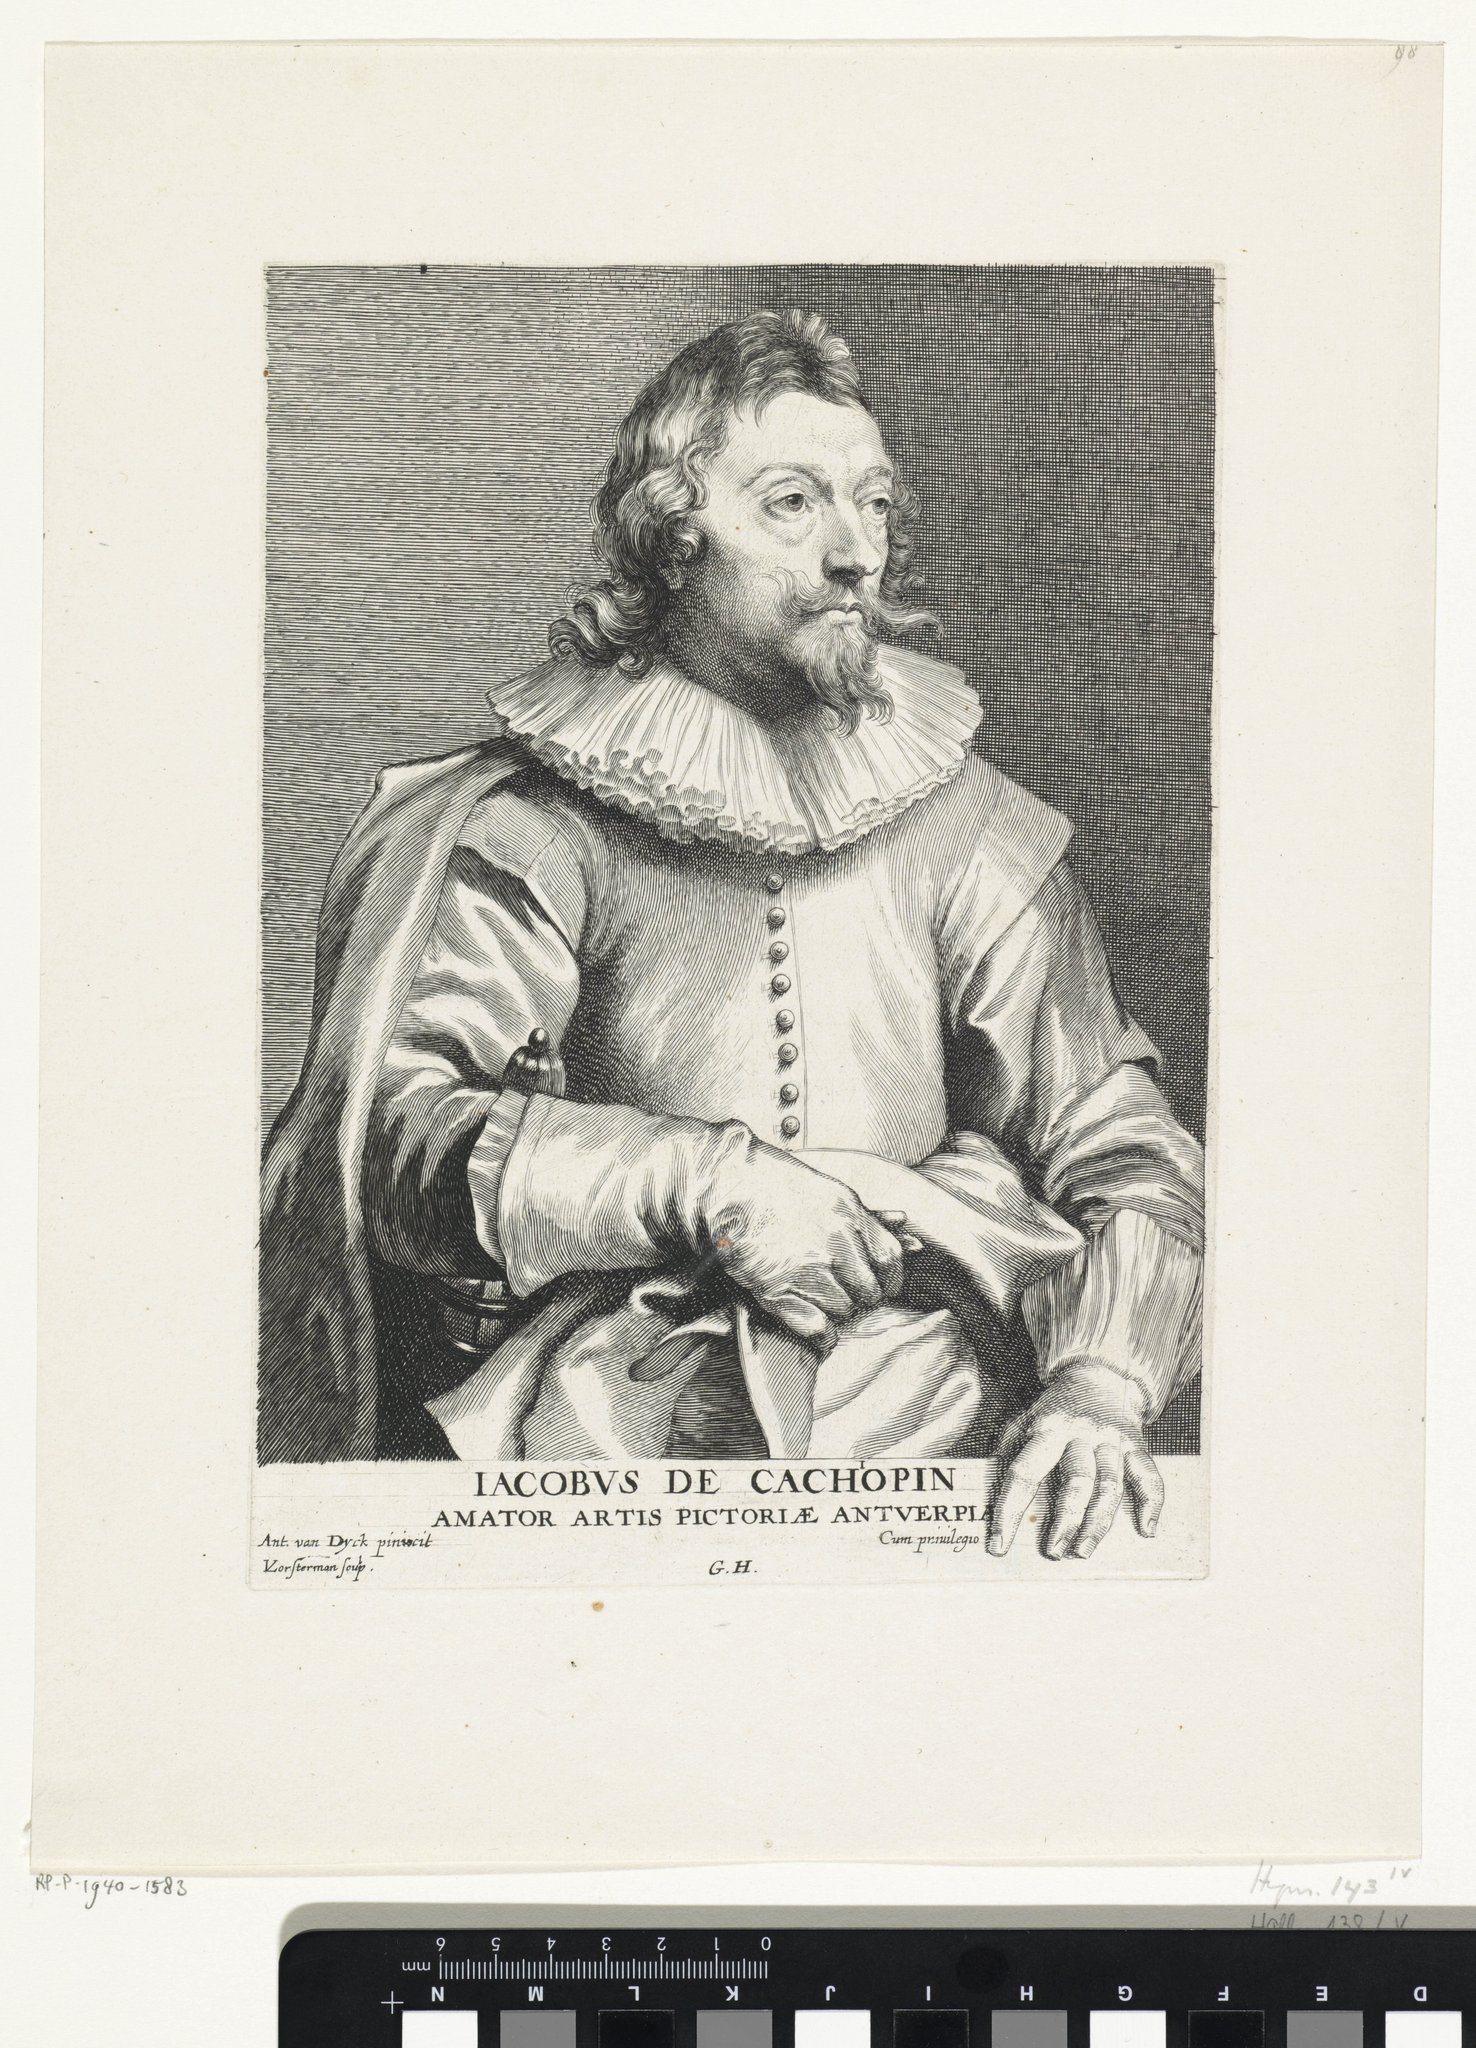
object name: print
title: Iconographie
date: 1645-1646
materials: paper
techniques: engraving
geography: antwerp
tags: gloves, mittens, etc.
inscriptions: collector's mark: Lugt 2760, collector's mark: Lugt 2228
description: Prent gebruikt voor: Icones principum, virorum doctorum, pictorum, chalcographorum, statuariorum nec non amatorum pictoriae artis numero centum ab Ant. van Dyck ad vivum expressae ejusque sumptibus aeri incisae. Antwerpen: Gillis Hendricx, [1645-1646].